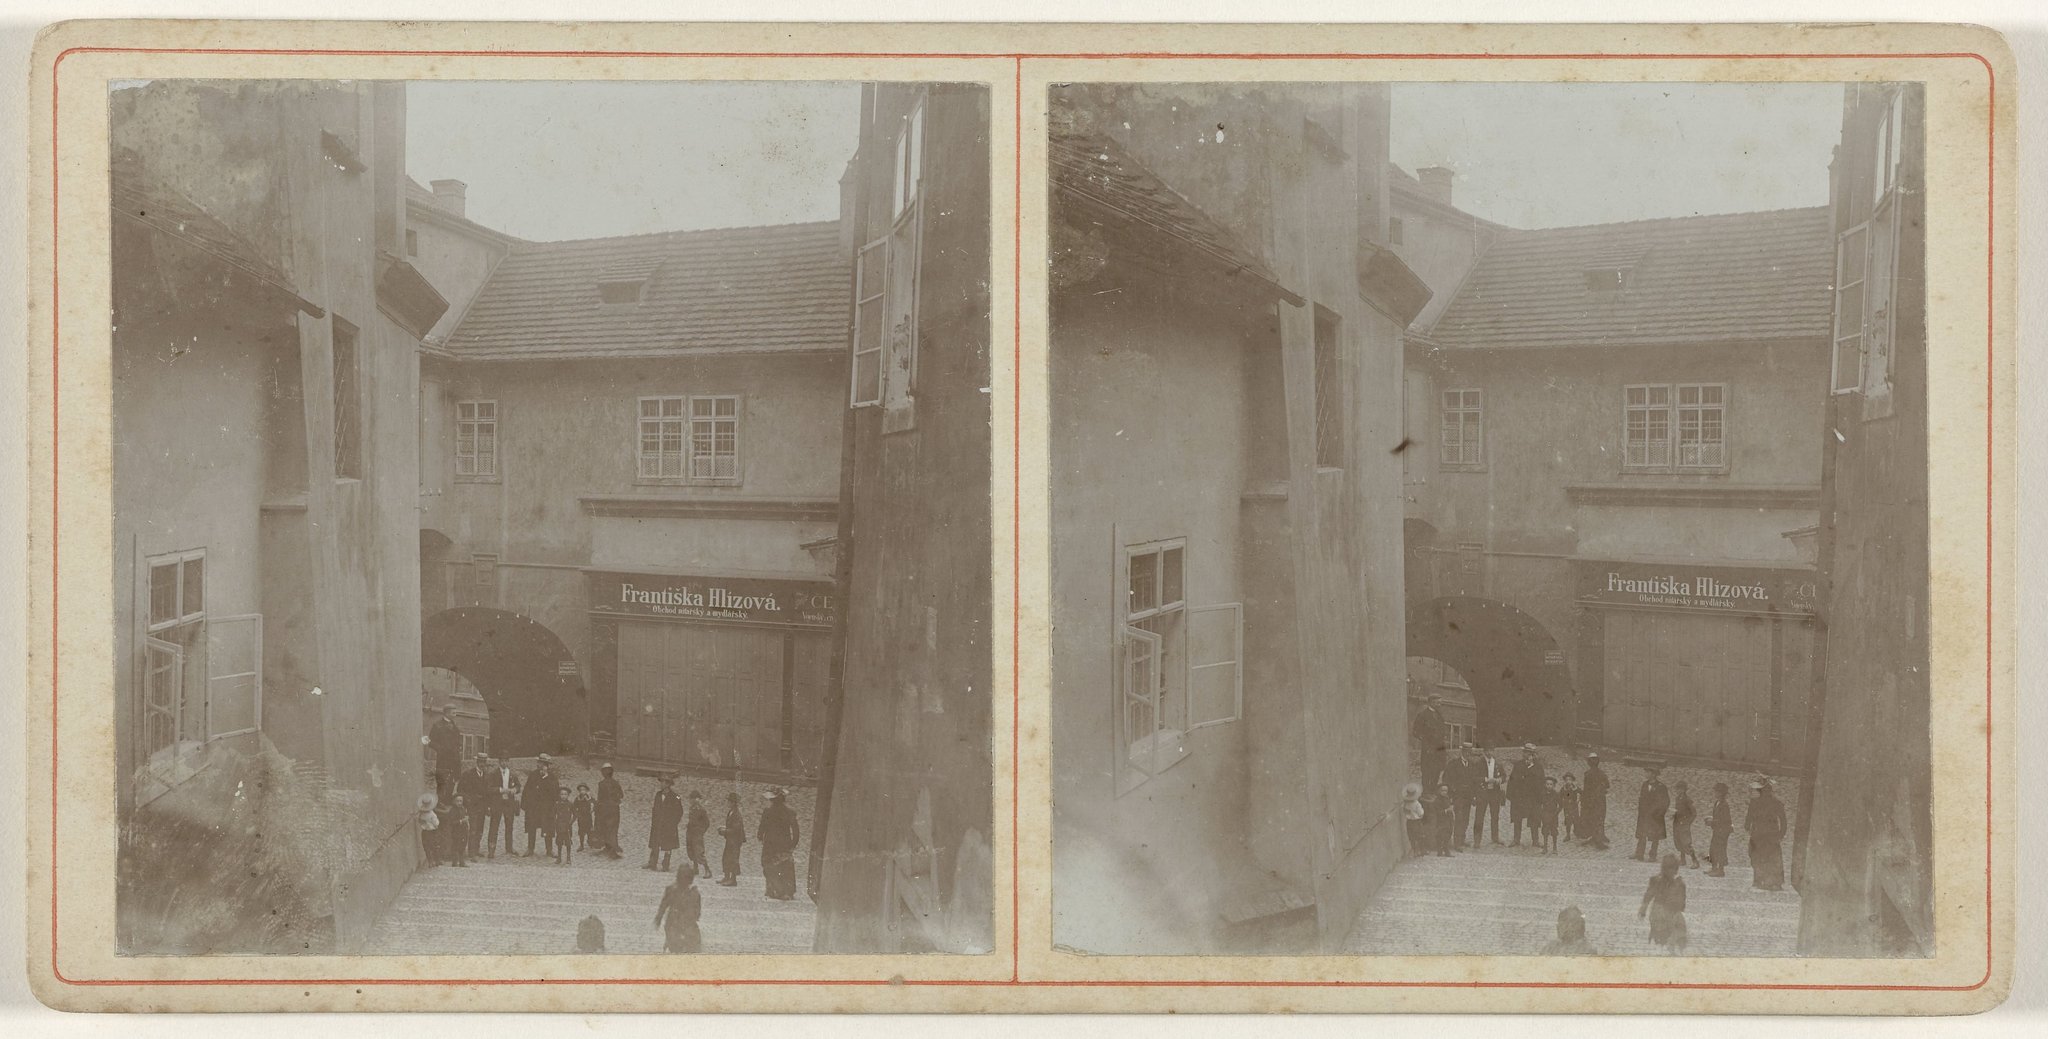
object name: stereograph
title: Groep mensen die in een straat voor een school staan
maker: geldolph adriaan kessler (dolph)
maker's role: fotograaf, industrieel, voetballer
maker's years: 1884-1945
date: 1903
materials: paper, photographic support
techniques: collodion silver print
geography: netherlands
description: Het gaat vermoedleijk om de familie Kessler in Tsjechië.